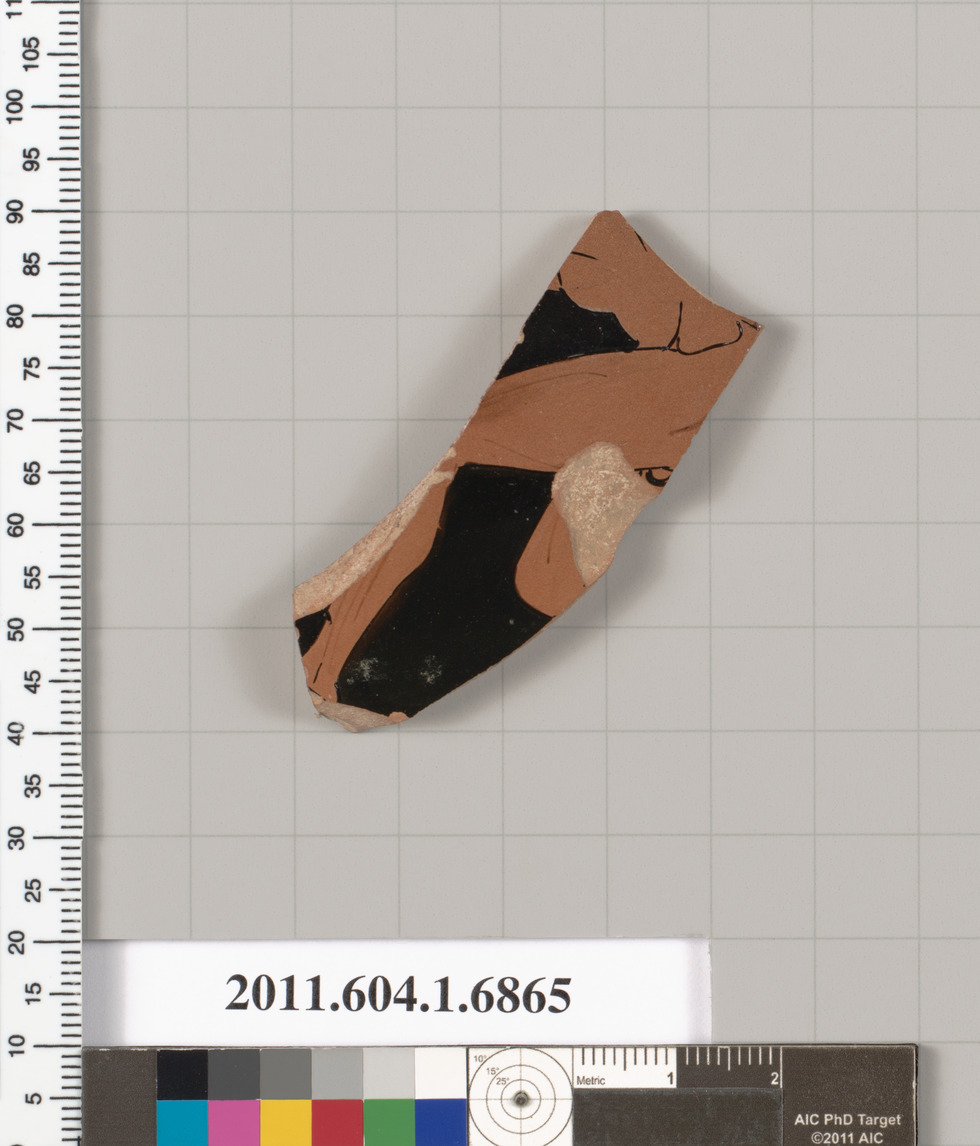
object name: kylix fragment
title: Terracotta fragment of a kylix (drinking cup)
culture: greek, attic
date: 490-470 BCE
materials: terracotta